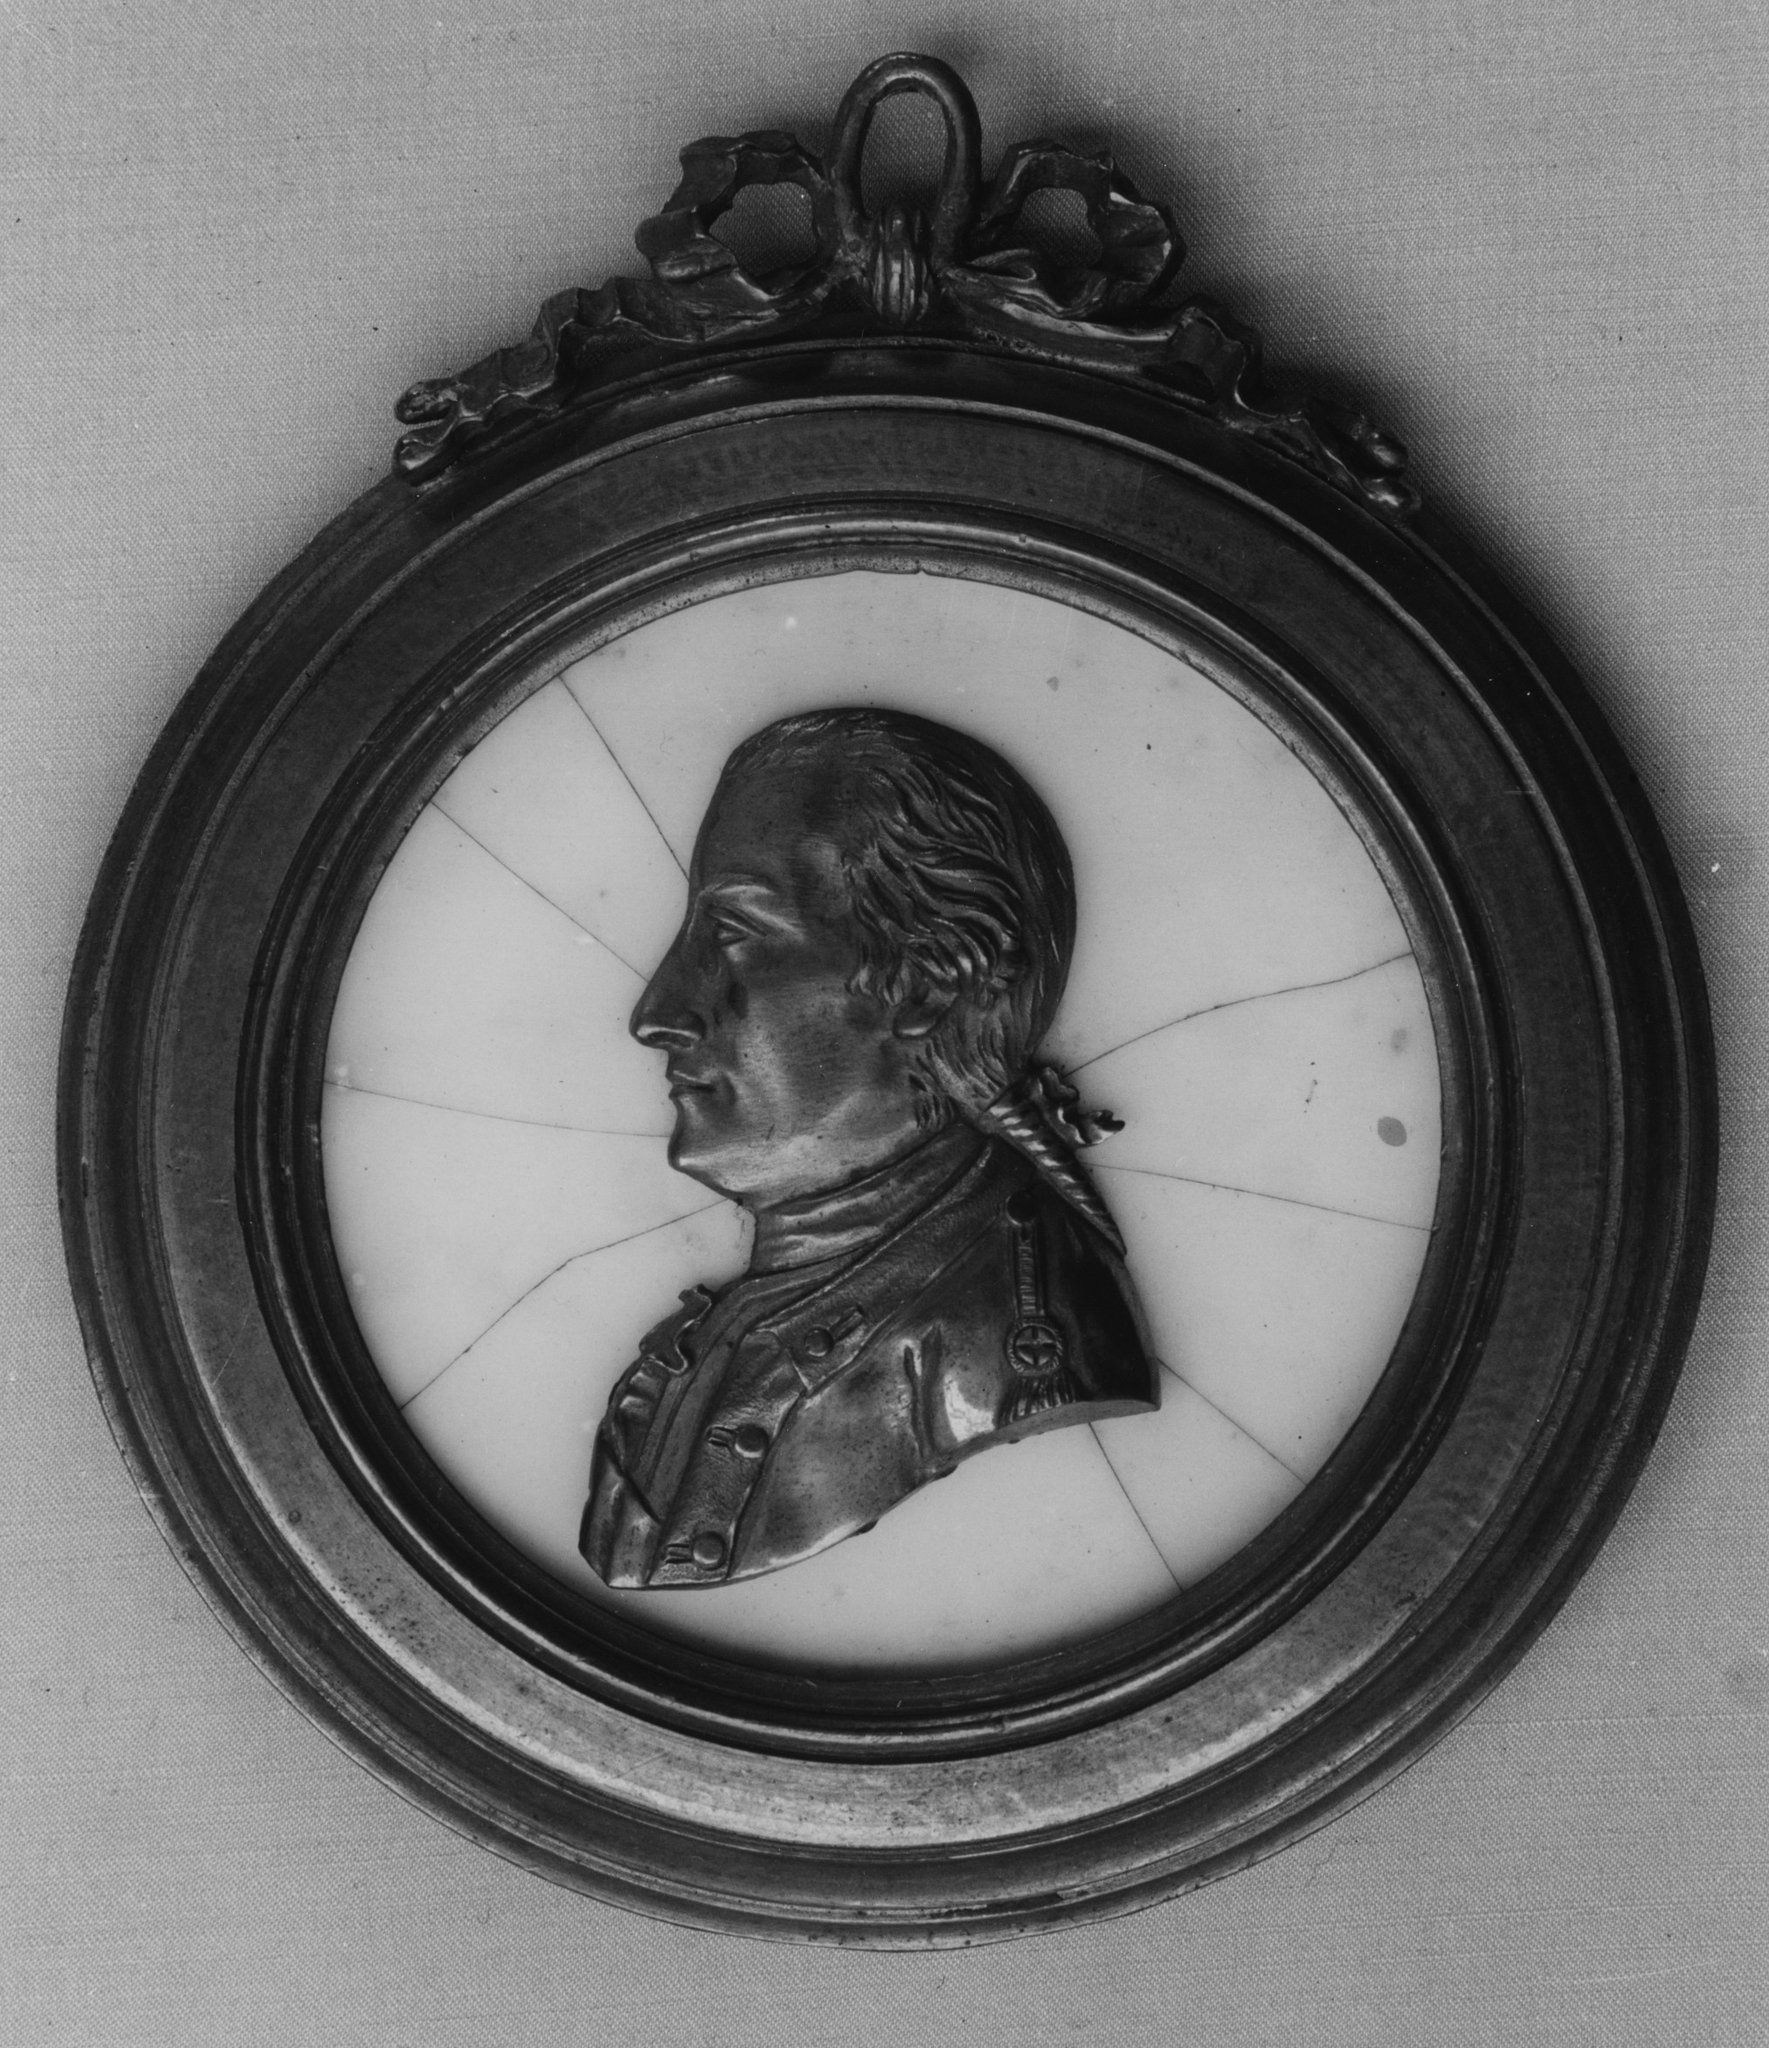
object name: medal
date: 1776-1783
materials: brass, gilt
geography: france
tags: men,profiles